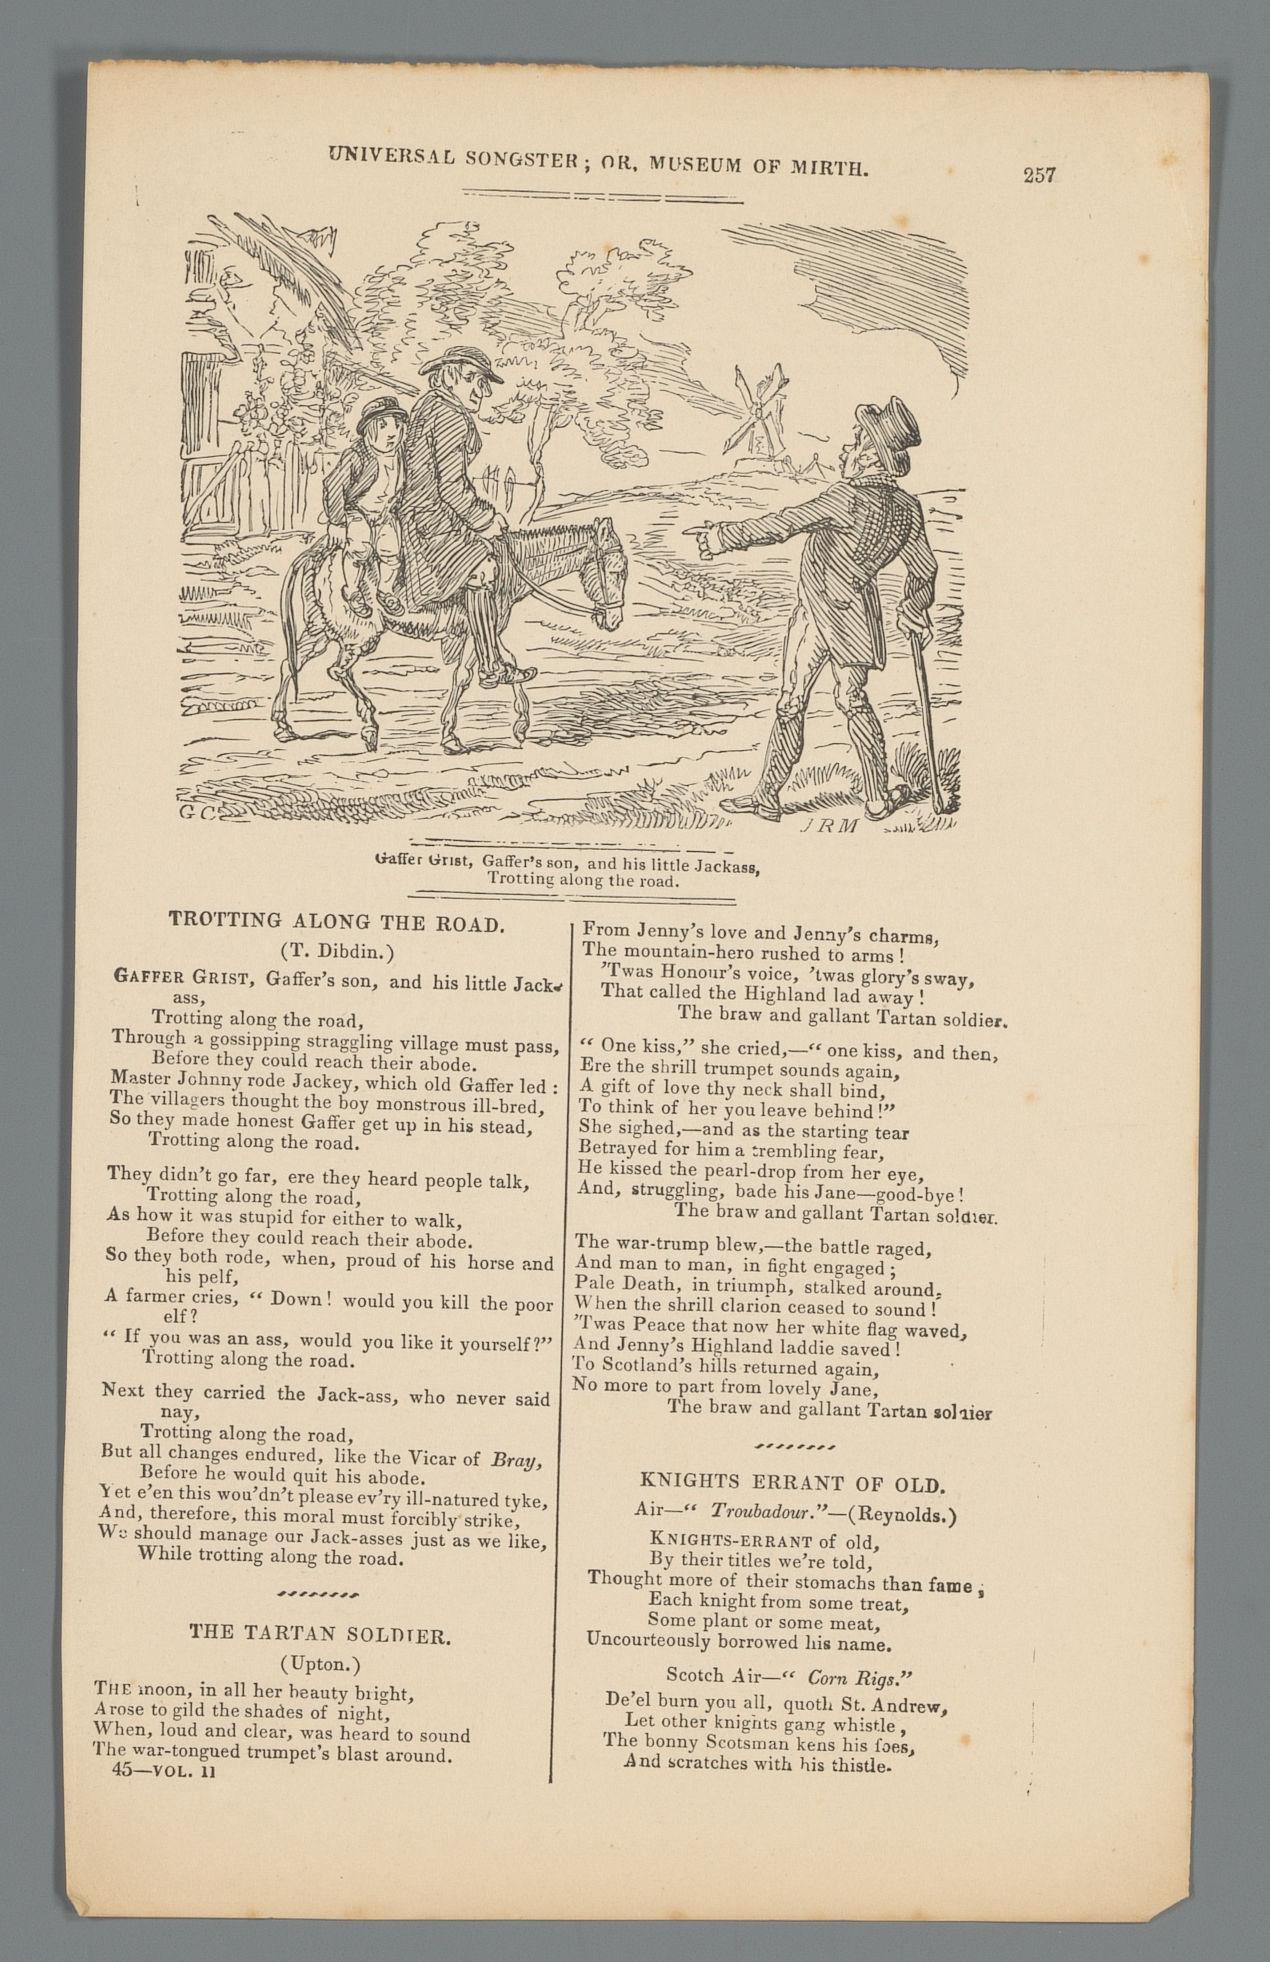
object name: print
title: Trotting along the road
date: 1826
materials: paper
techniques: engraving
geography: london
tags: ass, donkey, political caricatures and satires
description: Man met kind rijdend op een ezel worden wegens wreedheid terechtgewezen door een boze landman. Spotprent bij een blad met de tekst van het lied: Trotting along the road. Illustratie (p. 257/258) genomen uit een uitgave van de liederenbundel: Universal Songster, or Museum of Mirth, vol. II., eerst verschenen in 1826.